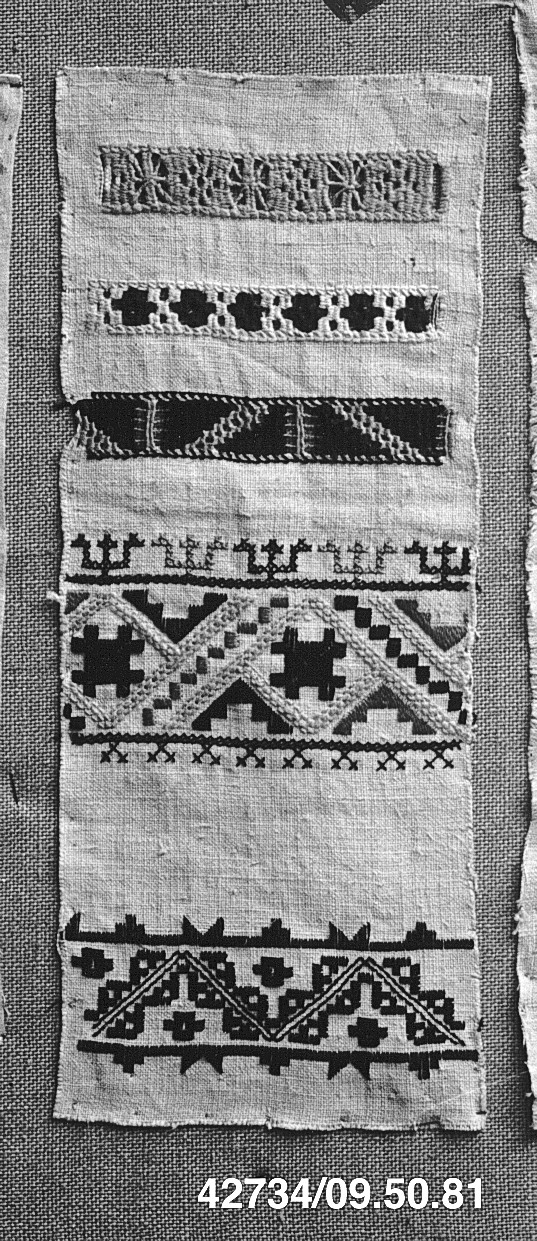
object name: sampler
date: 1701-1800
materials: linen, wool